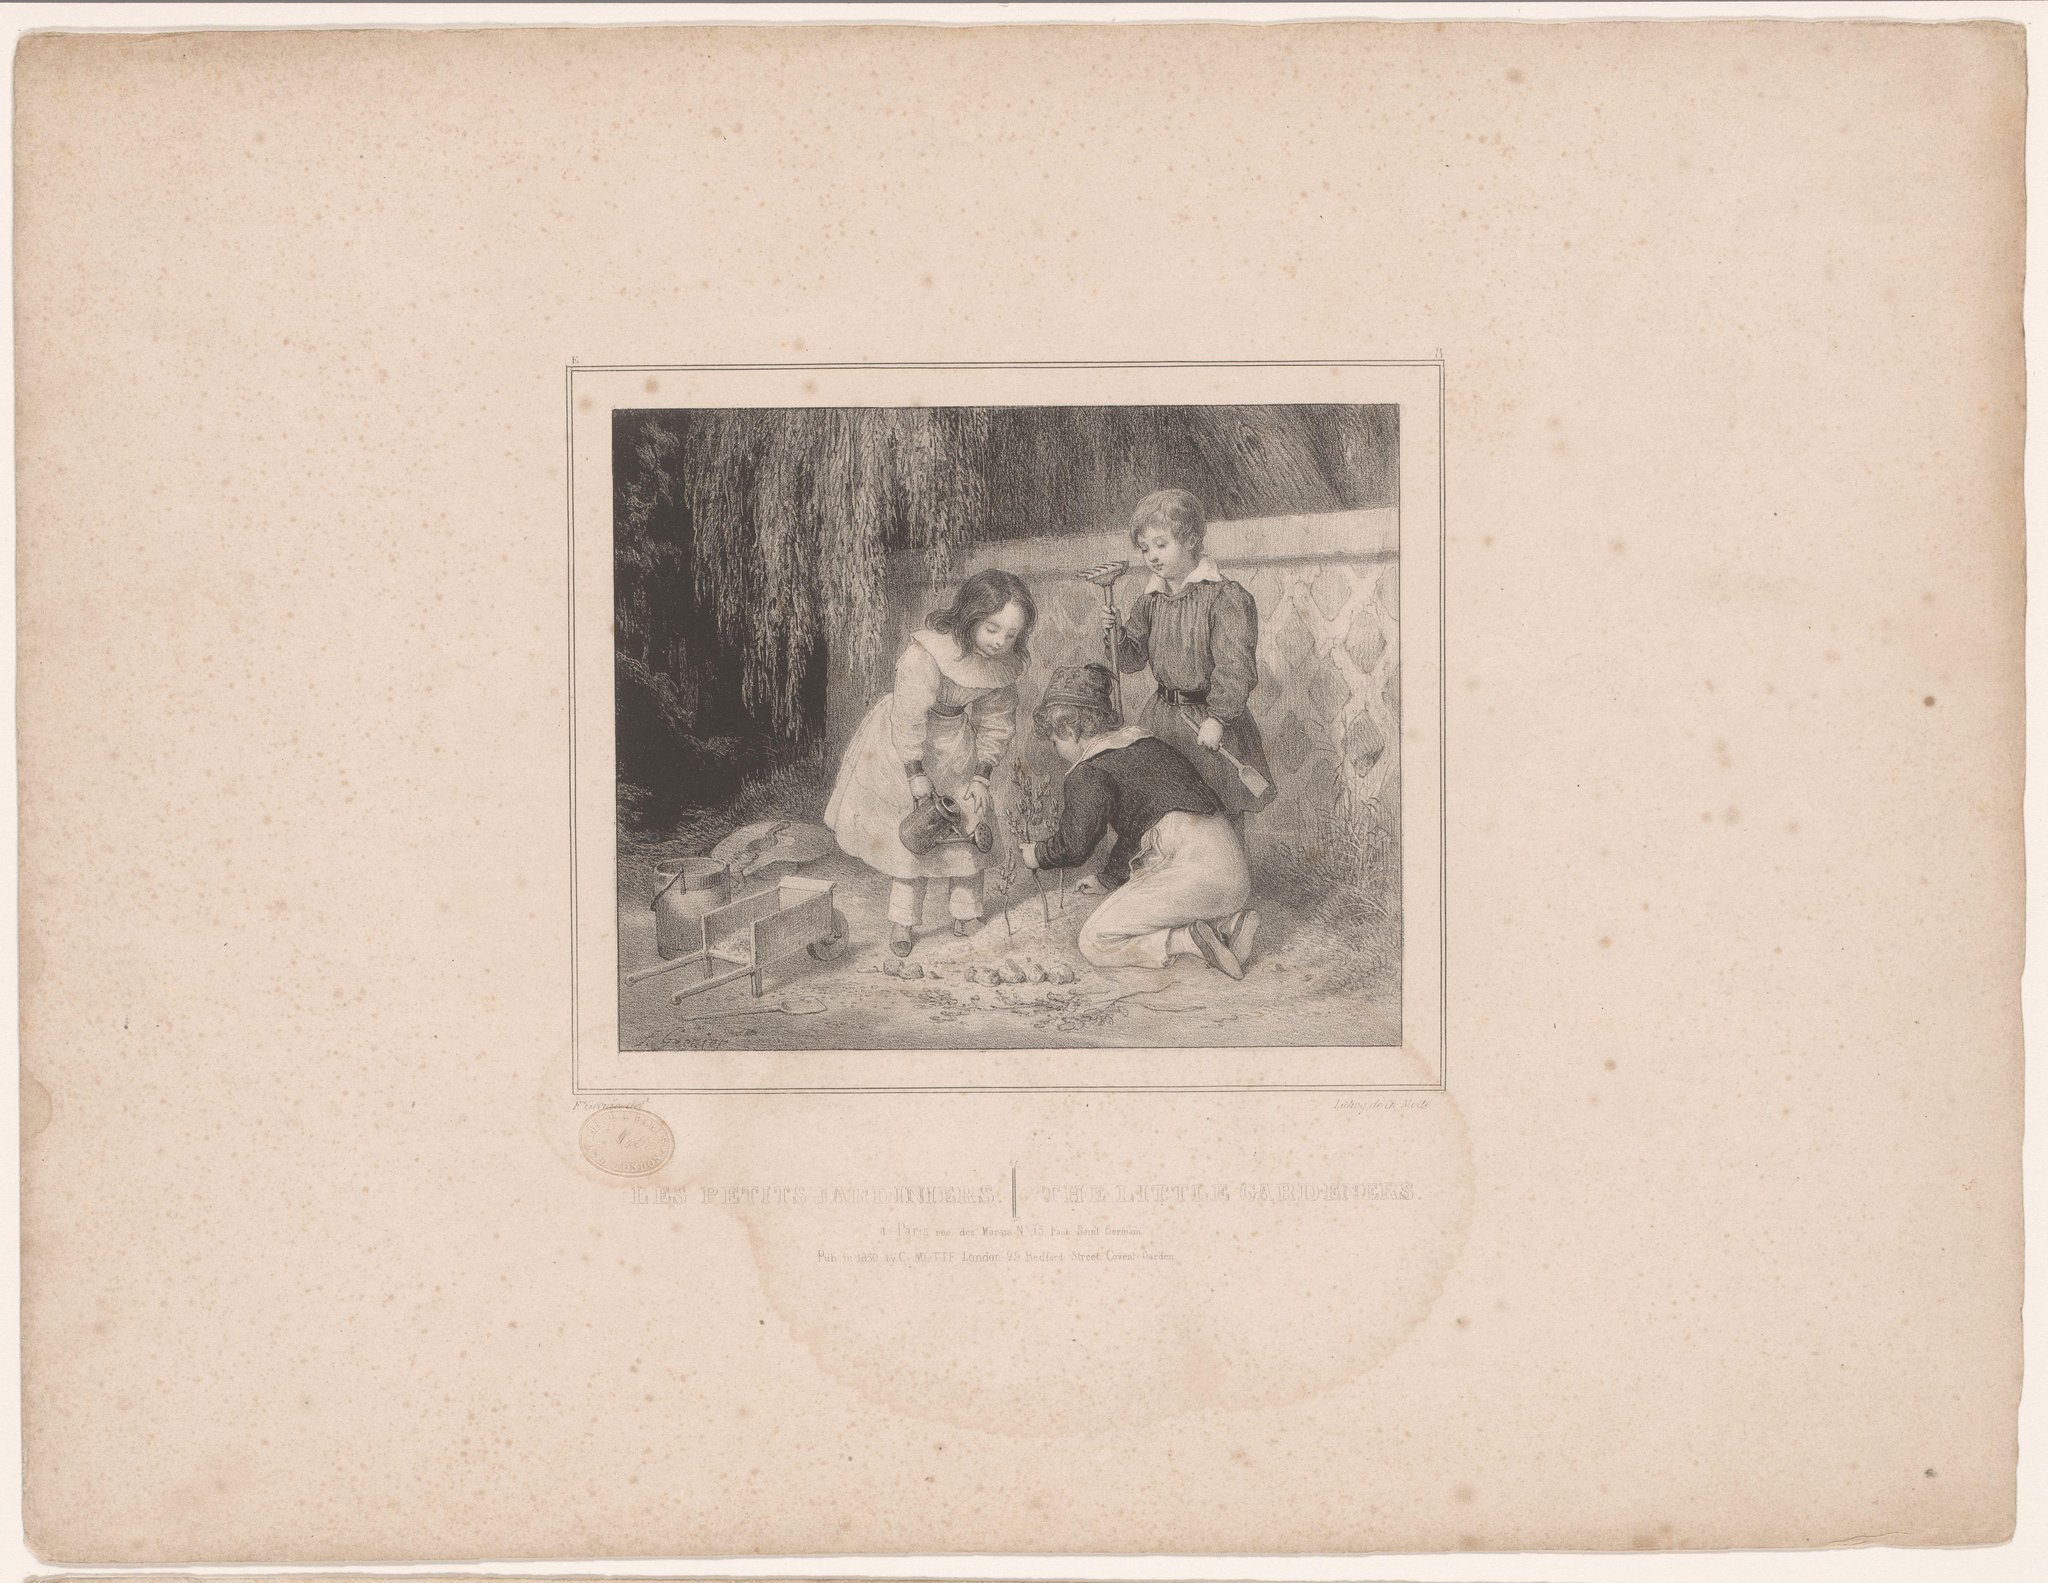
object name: print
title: Album de douze sujets (...)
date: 1830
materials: paper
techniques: lithograph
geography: paris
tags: child, watering plants, child with plant (games and plays), child (at home)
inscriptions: collector's mark: Lugt 2228a, check stamp: Lugt 1828b